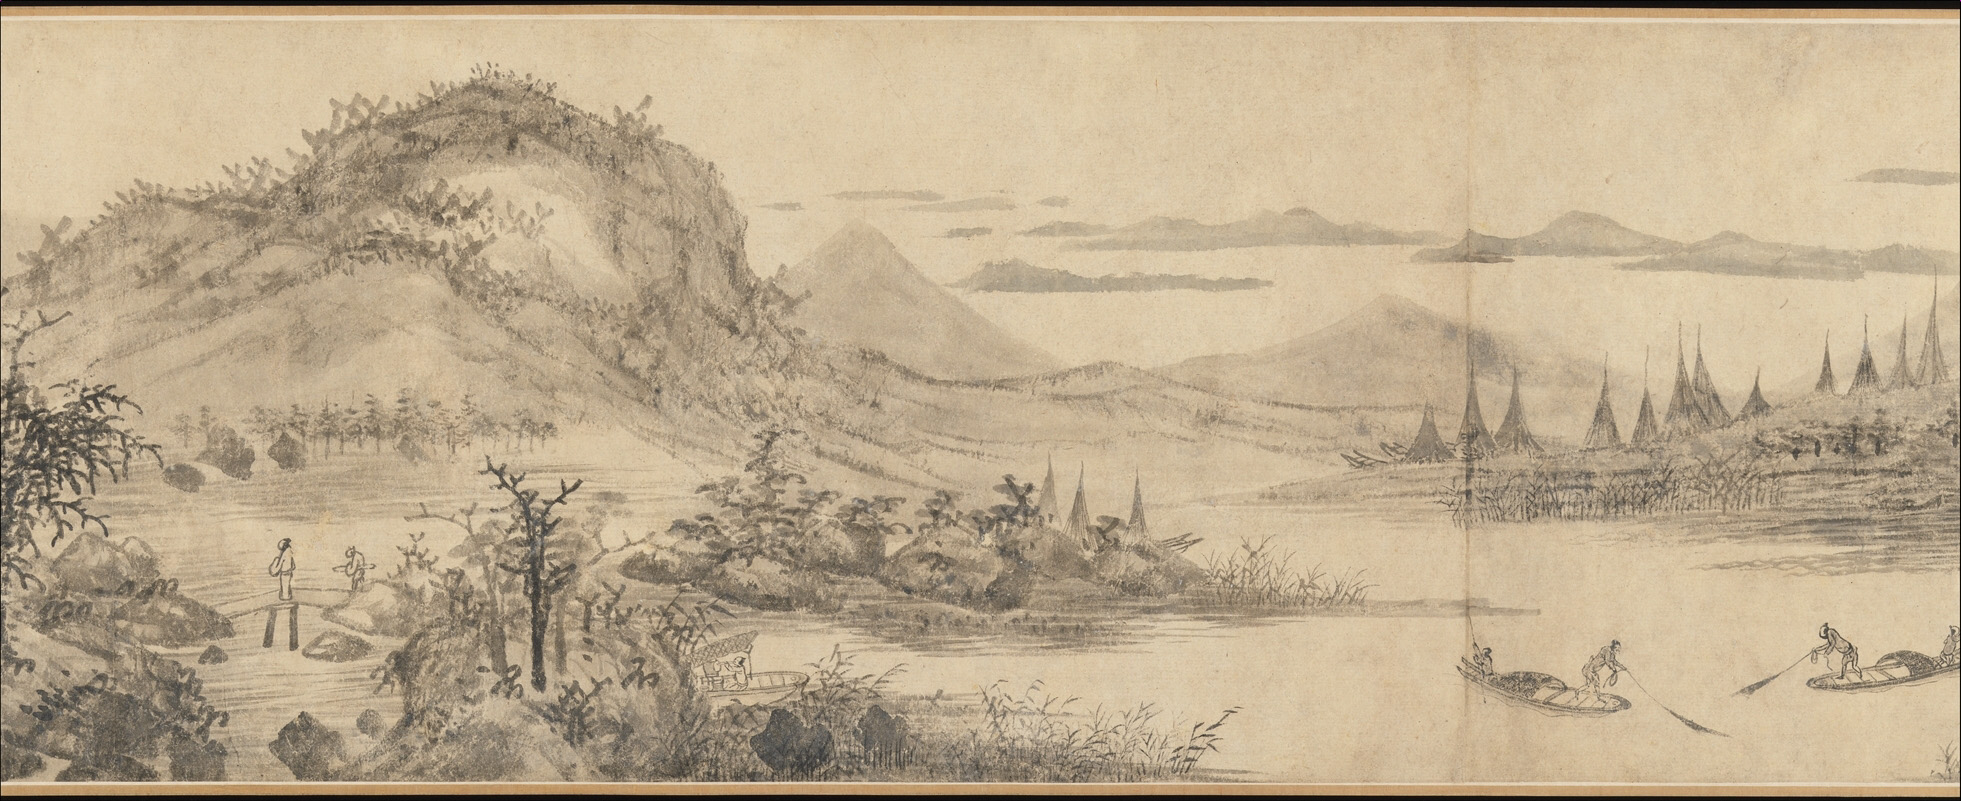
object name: handscroll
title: Joys of the Fisherman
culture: chinese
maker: wang fu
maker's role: artist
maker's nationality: chinese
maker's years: 1362-1416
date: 1410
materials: ink, paper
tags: men,fishing,landscapes,boats